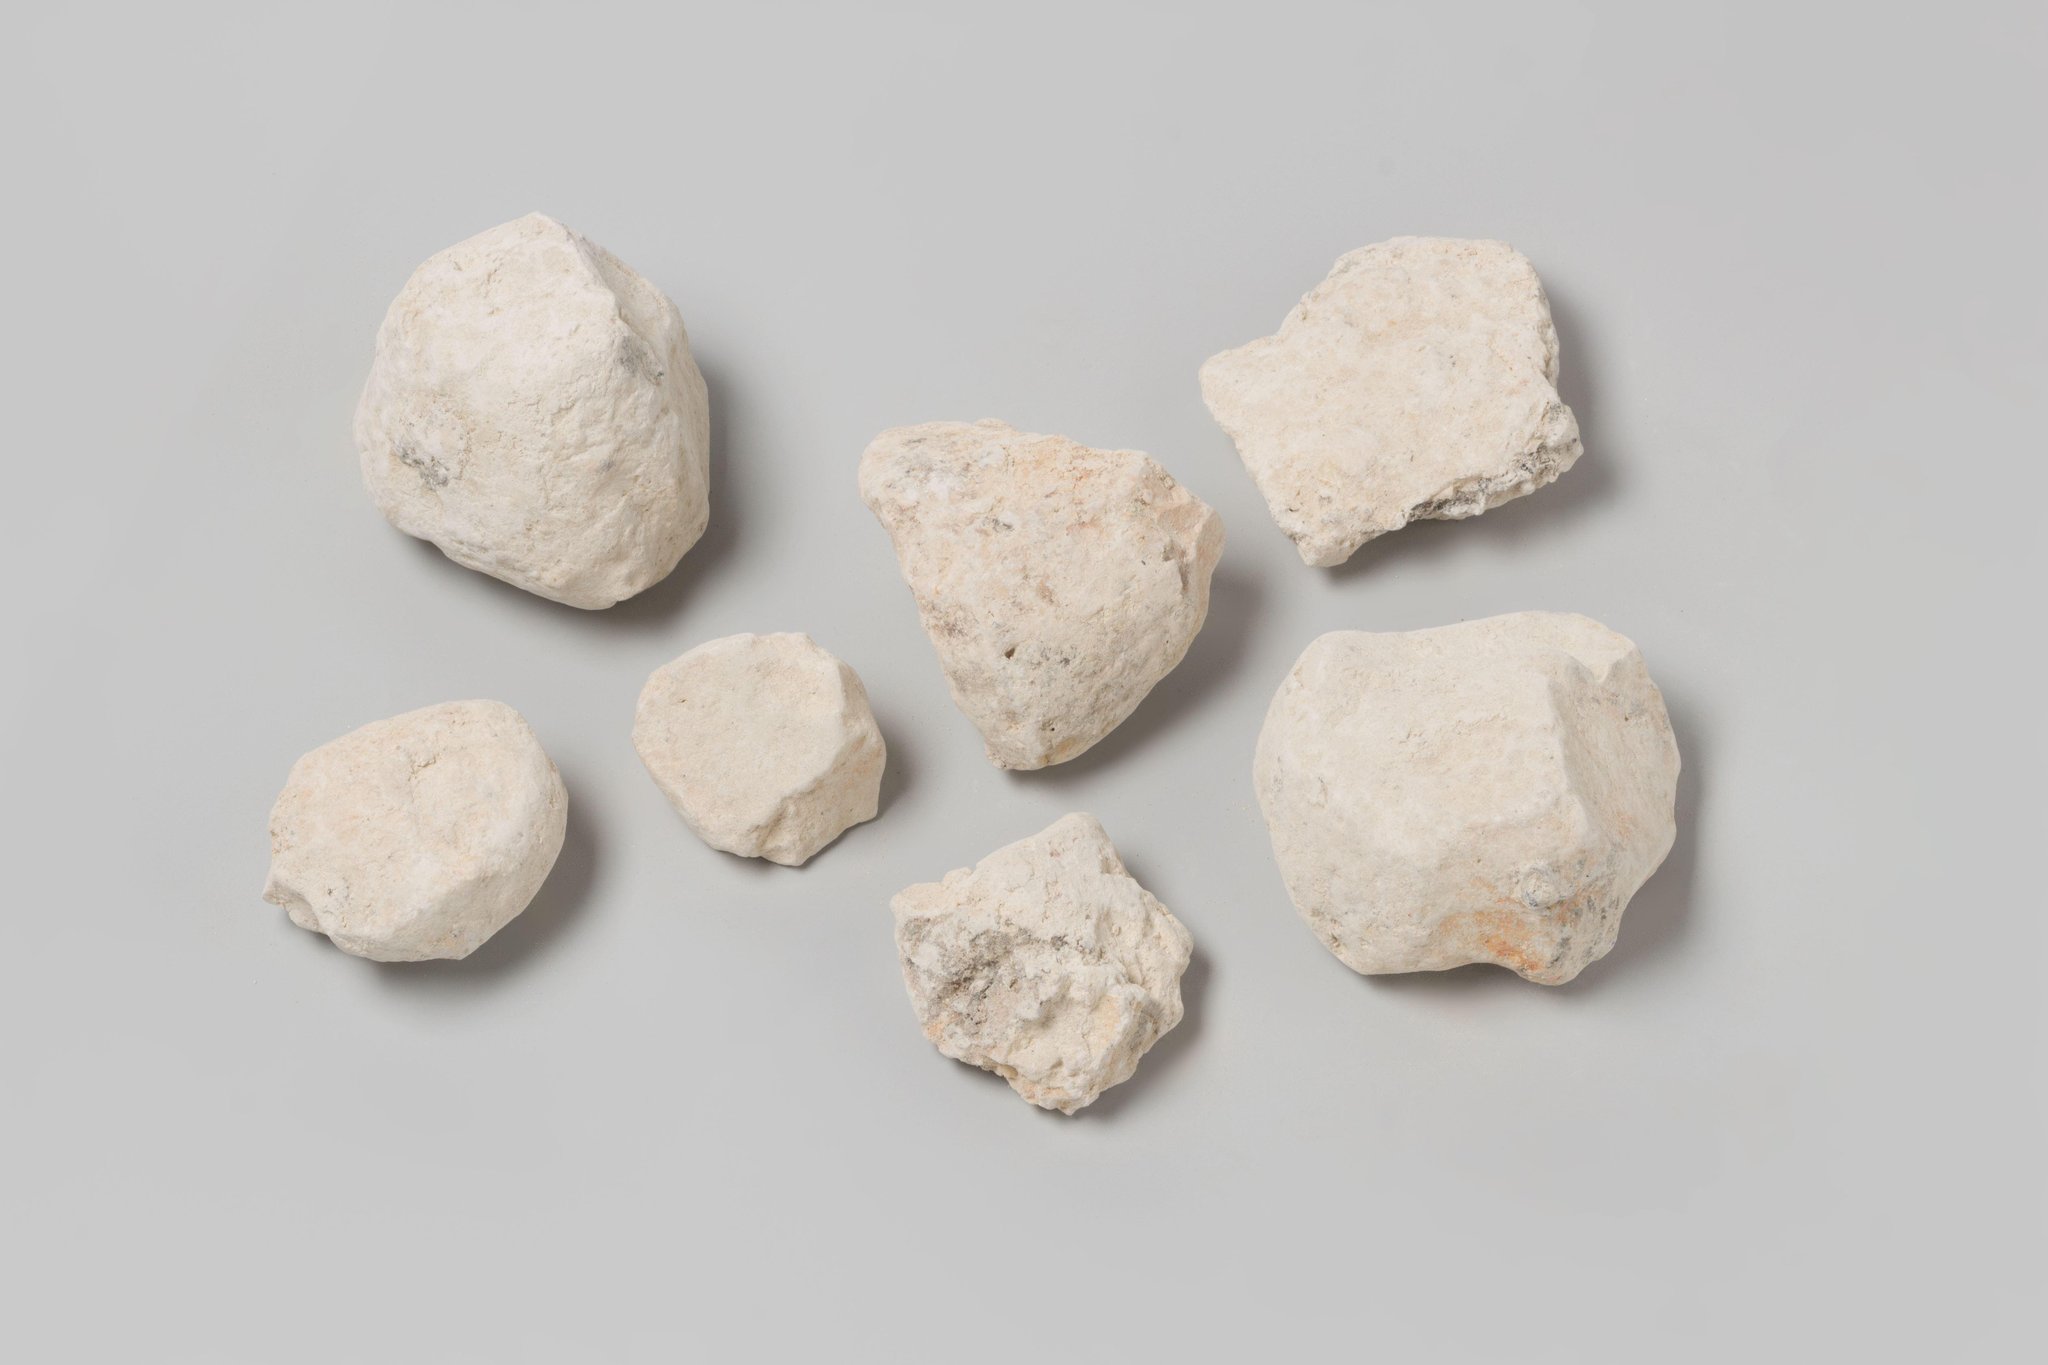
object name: scheepswrakvondst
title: Fragmenten en gruis van gips uit het wrak van de Oost-Indiëvaarder Hollandia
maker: Anonymous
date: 1700-1743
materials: gypsum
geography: netherlands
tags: verenigde oostindische compagnie, hollandia (schip), annet